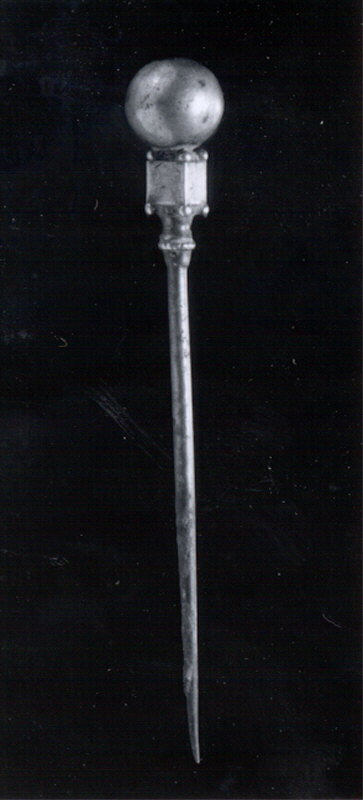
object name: pin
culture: parthian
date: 300-101 BCE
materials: silver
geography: iran (?)